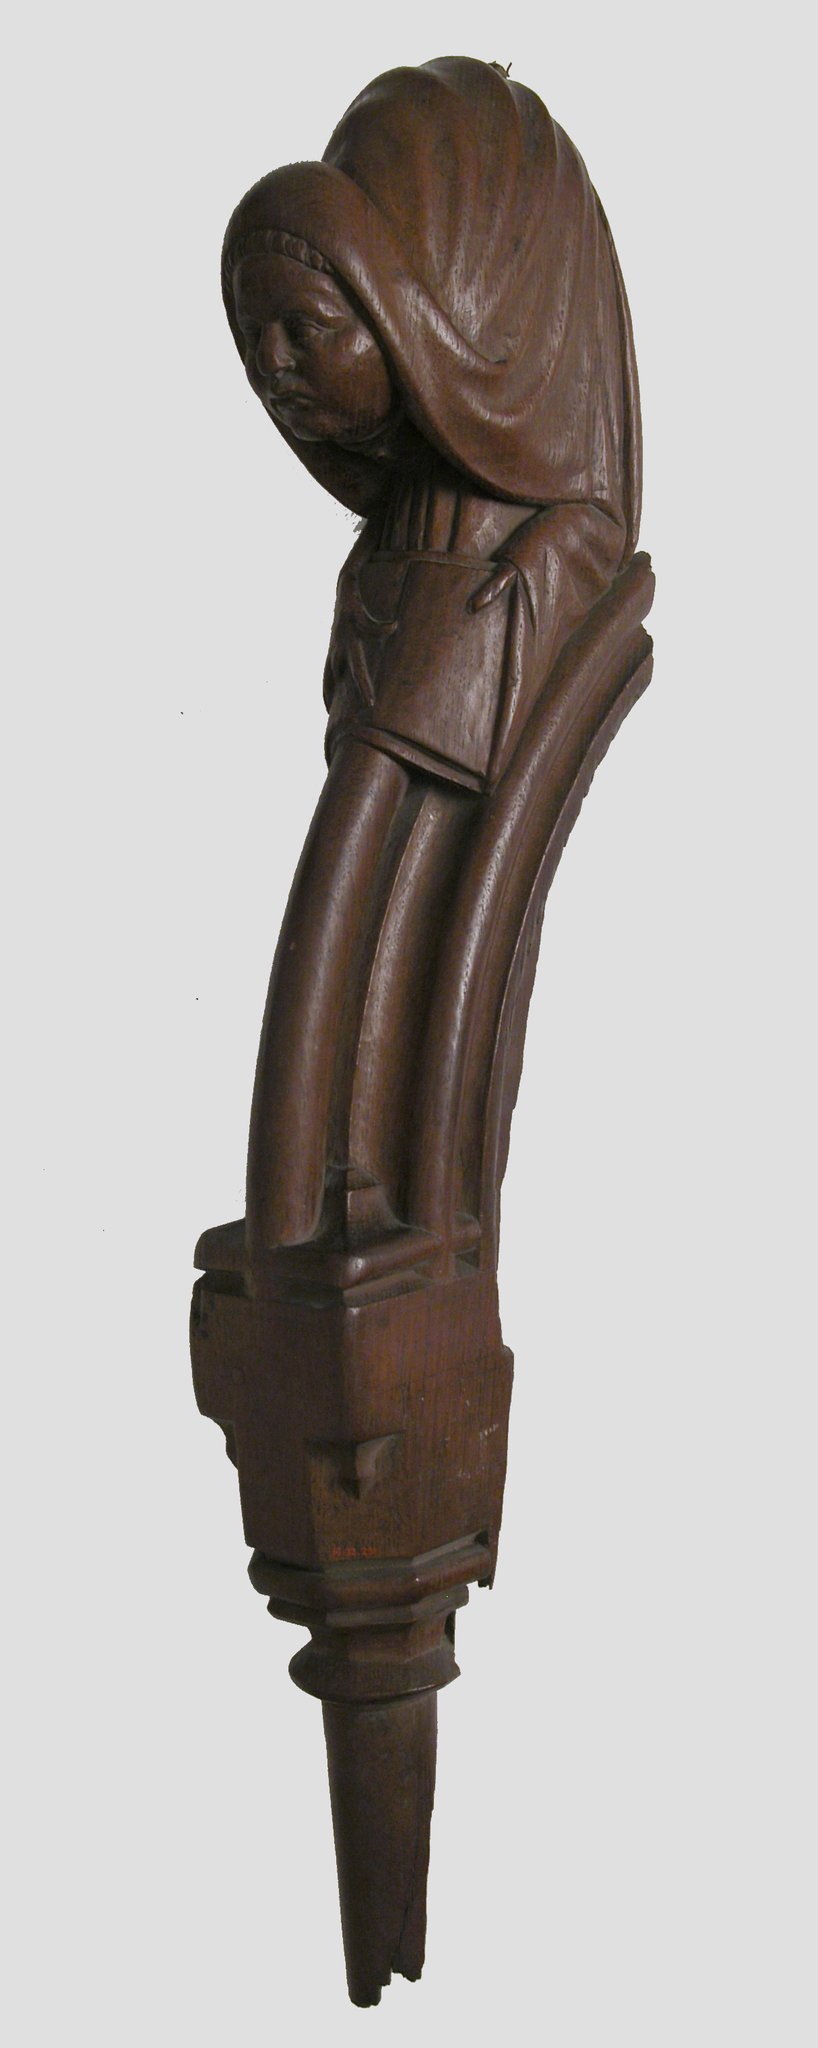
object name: choir stall fragment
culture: french or south netherlandish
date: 1401-1600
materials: wood